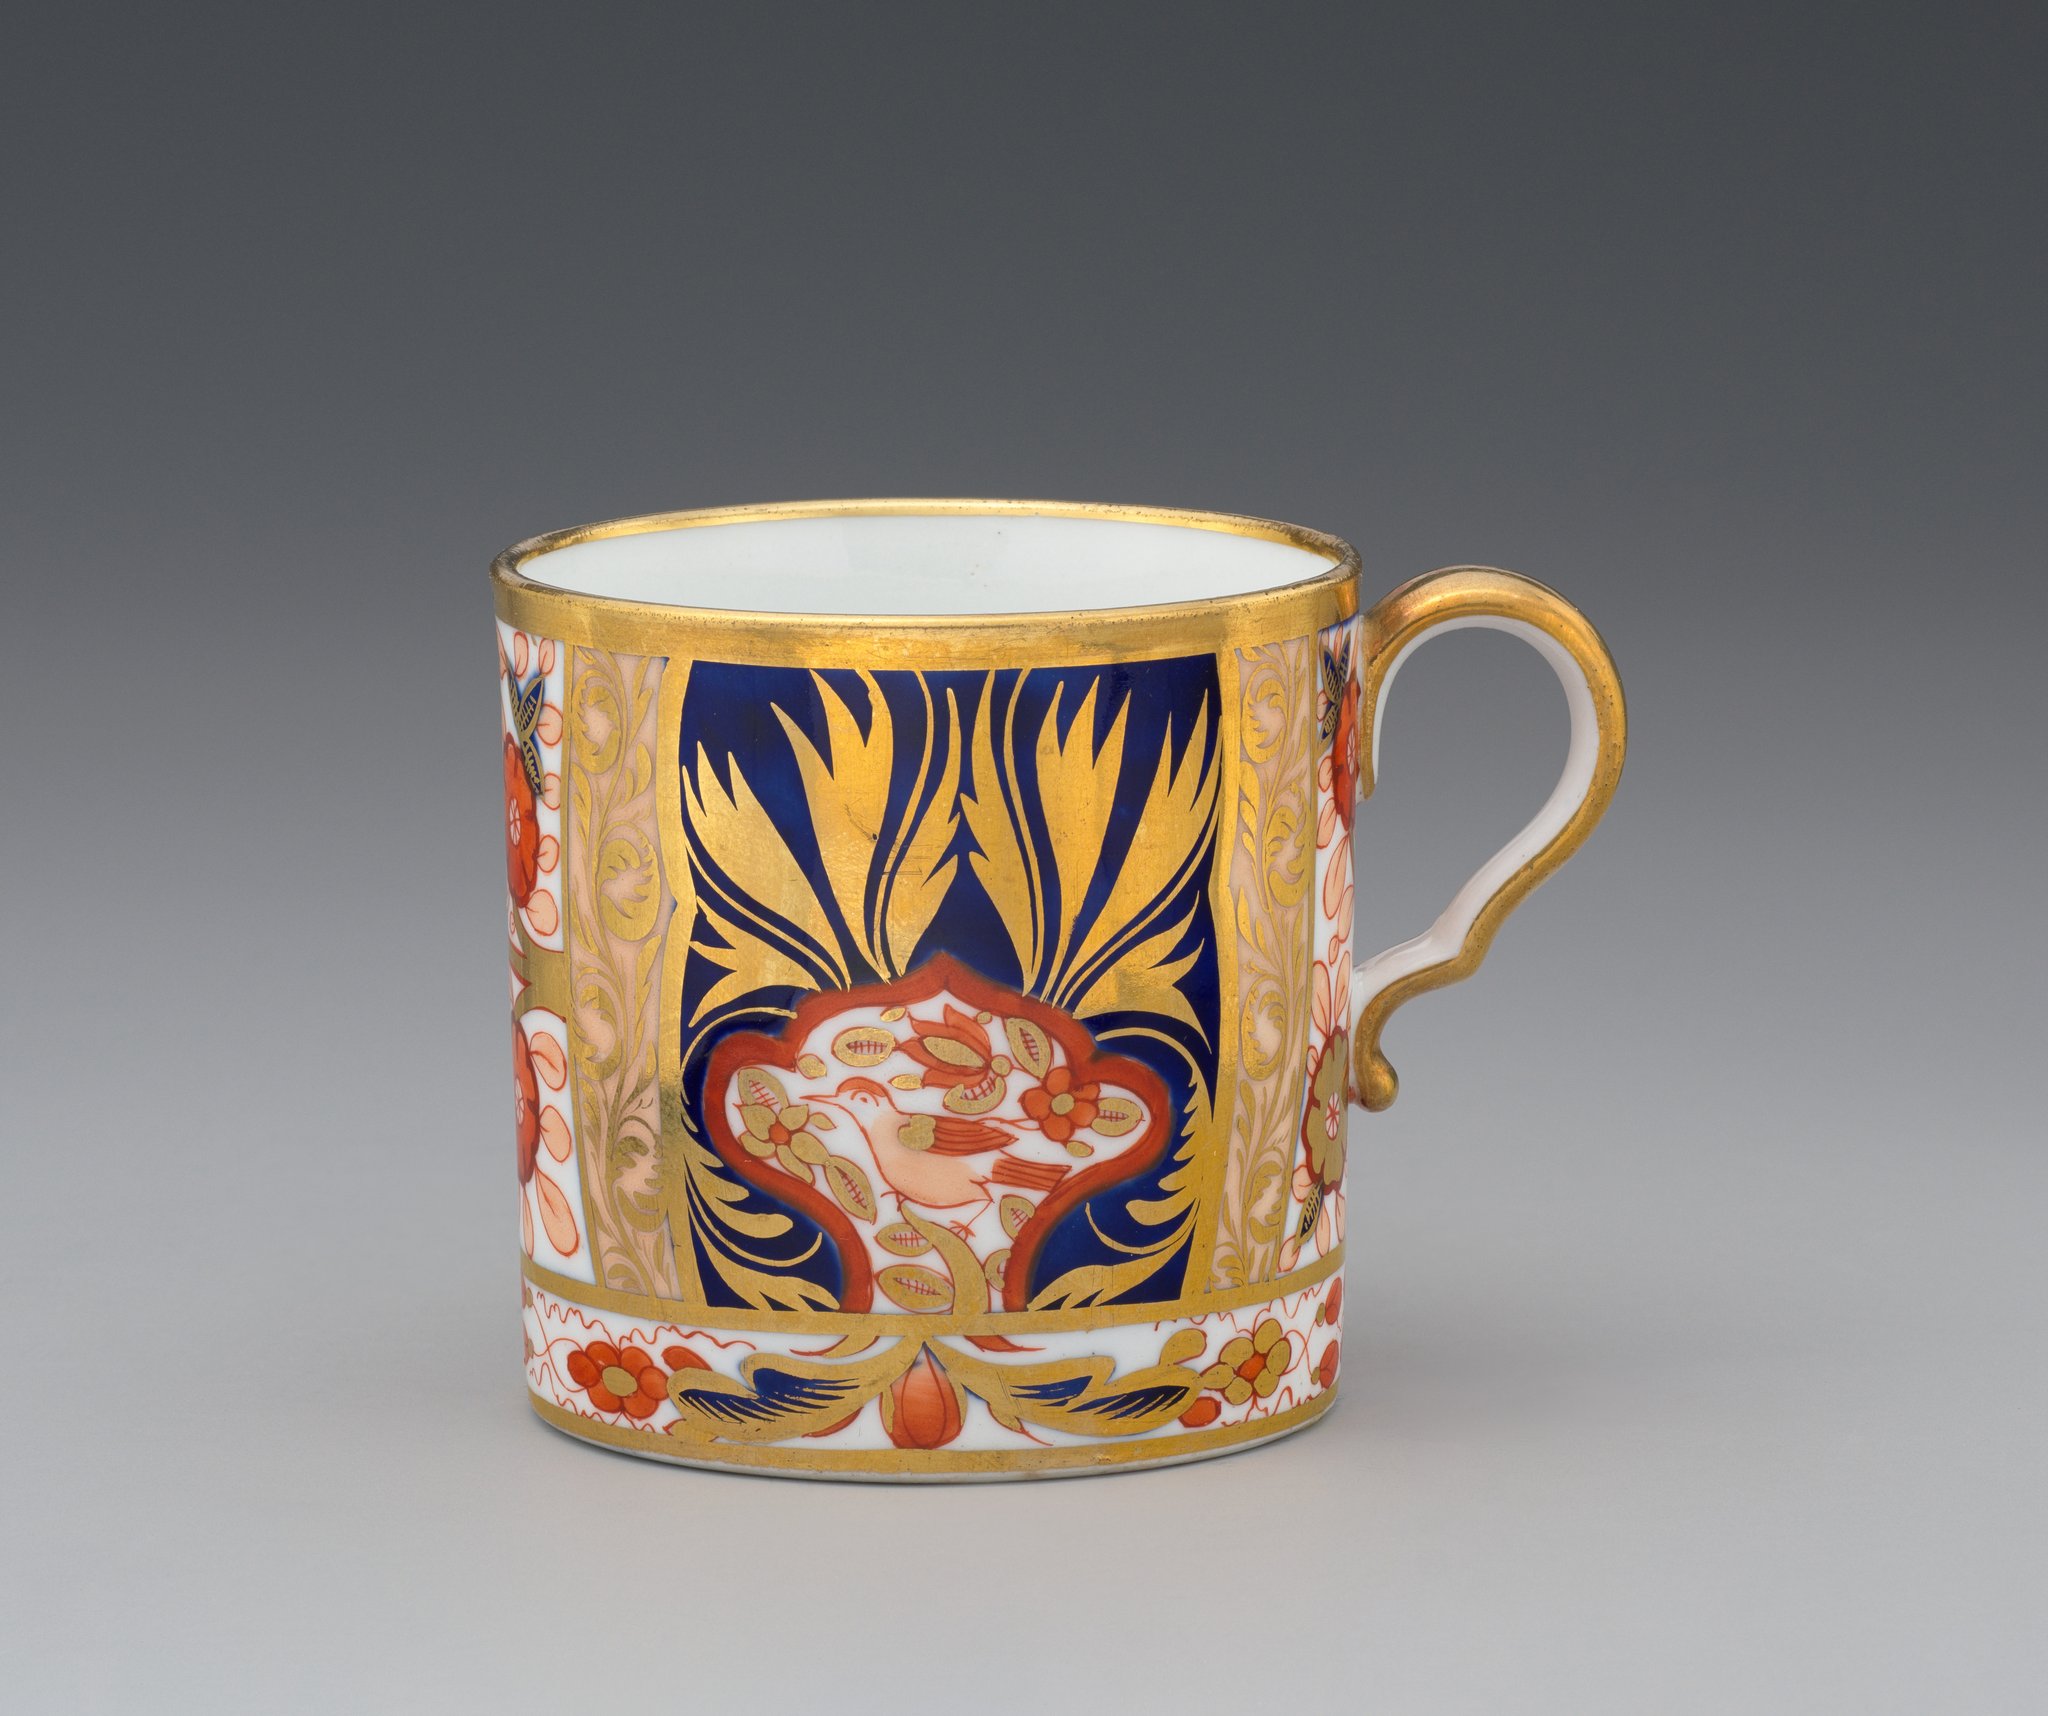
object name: cup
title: Cup (part of a service)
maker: j. spode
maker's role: factory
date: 1800-1830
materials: soft paste porcelain